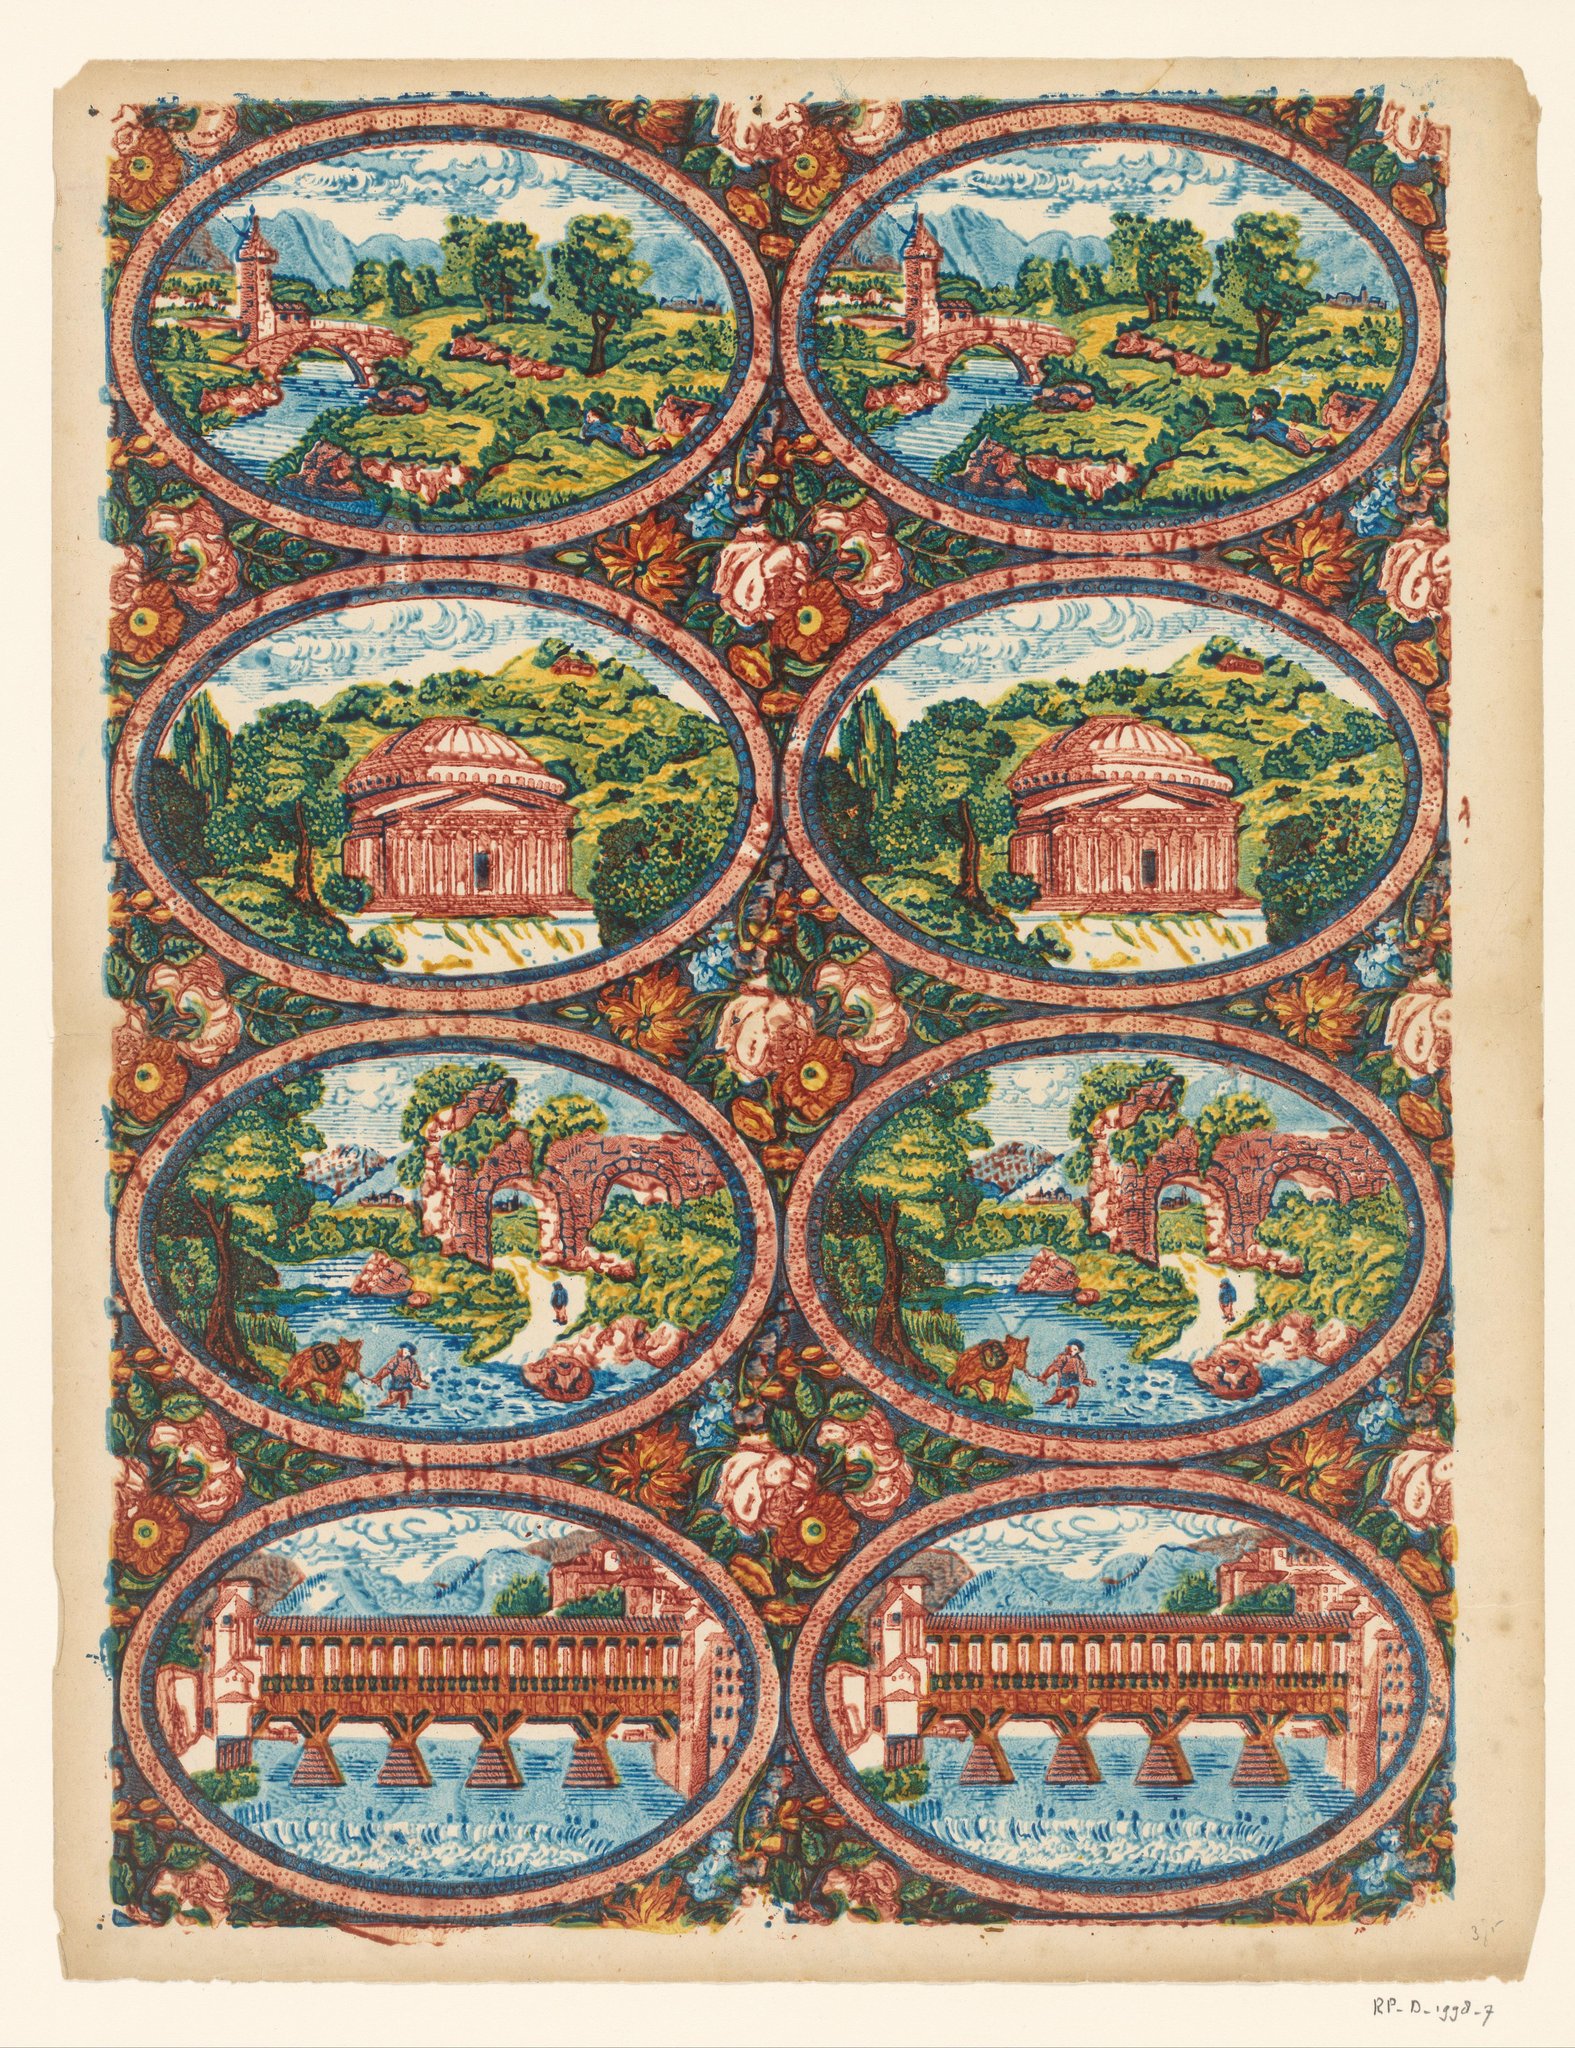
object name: printed paper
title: Blad met banen met vier landschappen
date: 1750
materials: paper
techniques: printing block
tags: landscape with bridge, viaduct or aqueduct, landscape with ruins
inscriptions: collector's mark: Lugt 2228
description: Blad met twee banen met vier landschappen met bruggen en ruïnes in ovalen.